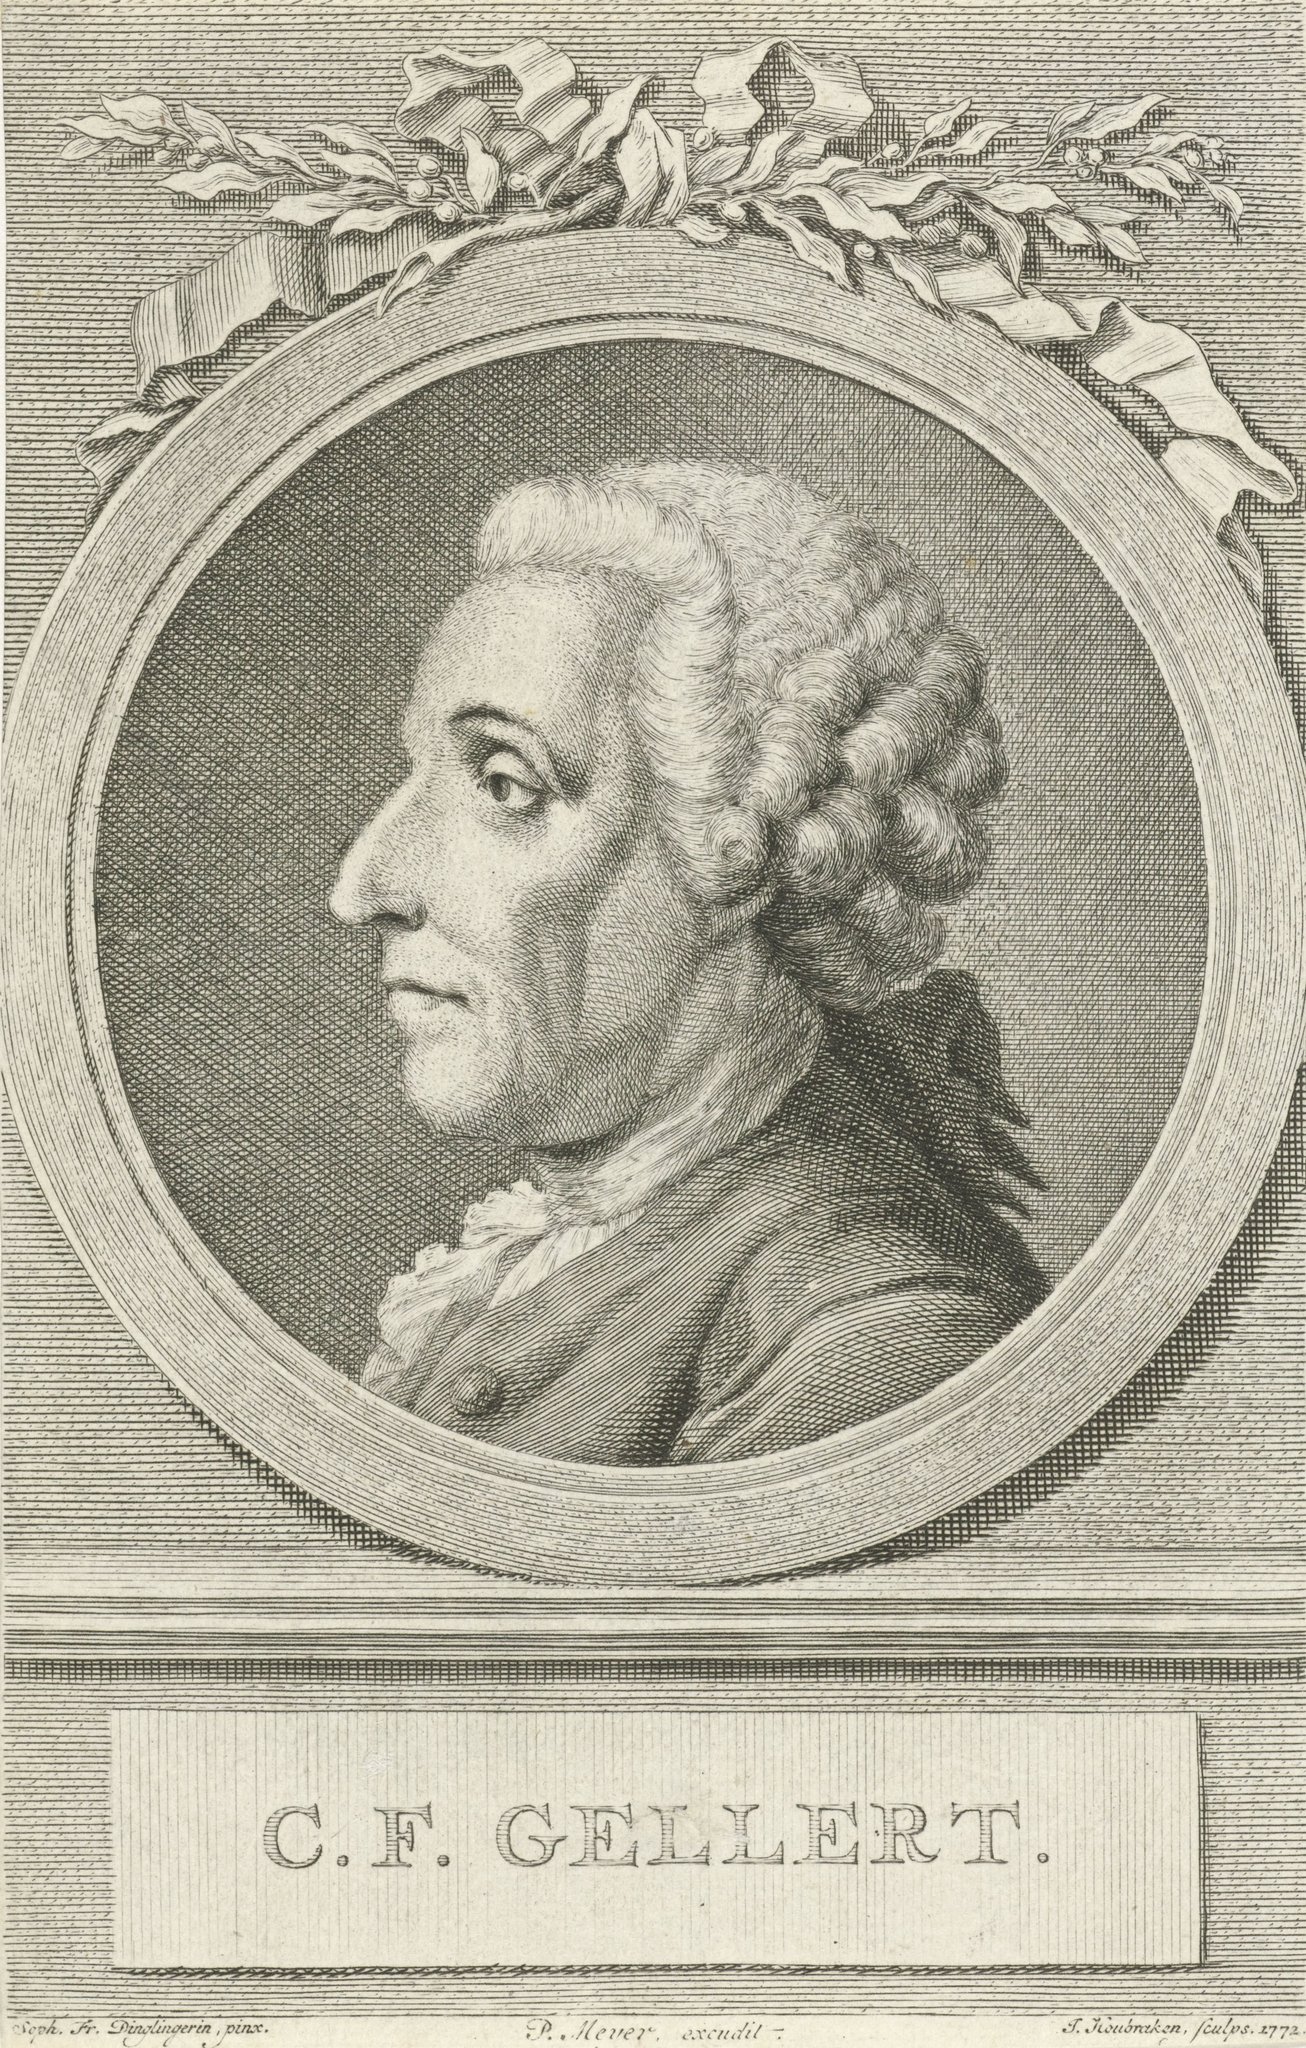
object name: print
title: C.F. Gellert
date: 1772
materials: paper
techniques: engraving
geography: amsterdam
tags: leipzig, dichter, schrijver, christian fürchtegott gellert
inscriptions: collector's mark: Lugt 2228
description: Buste naar links van Christian Furchtegott Gellert in een medaillon, bovenaan versierd met een strik en lauriertakken. Het portret rust op een plint waarop een veld met zijn naam.